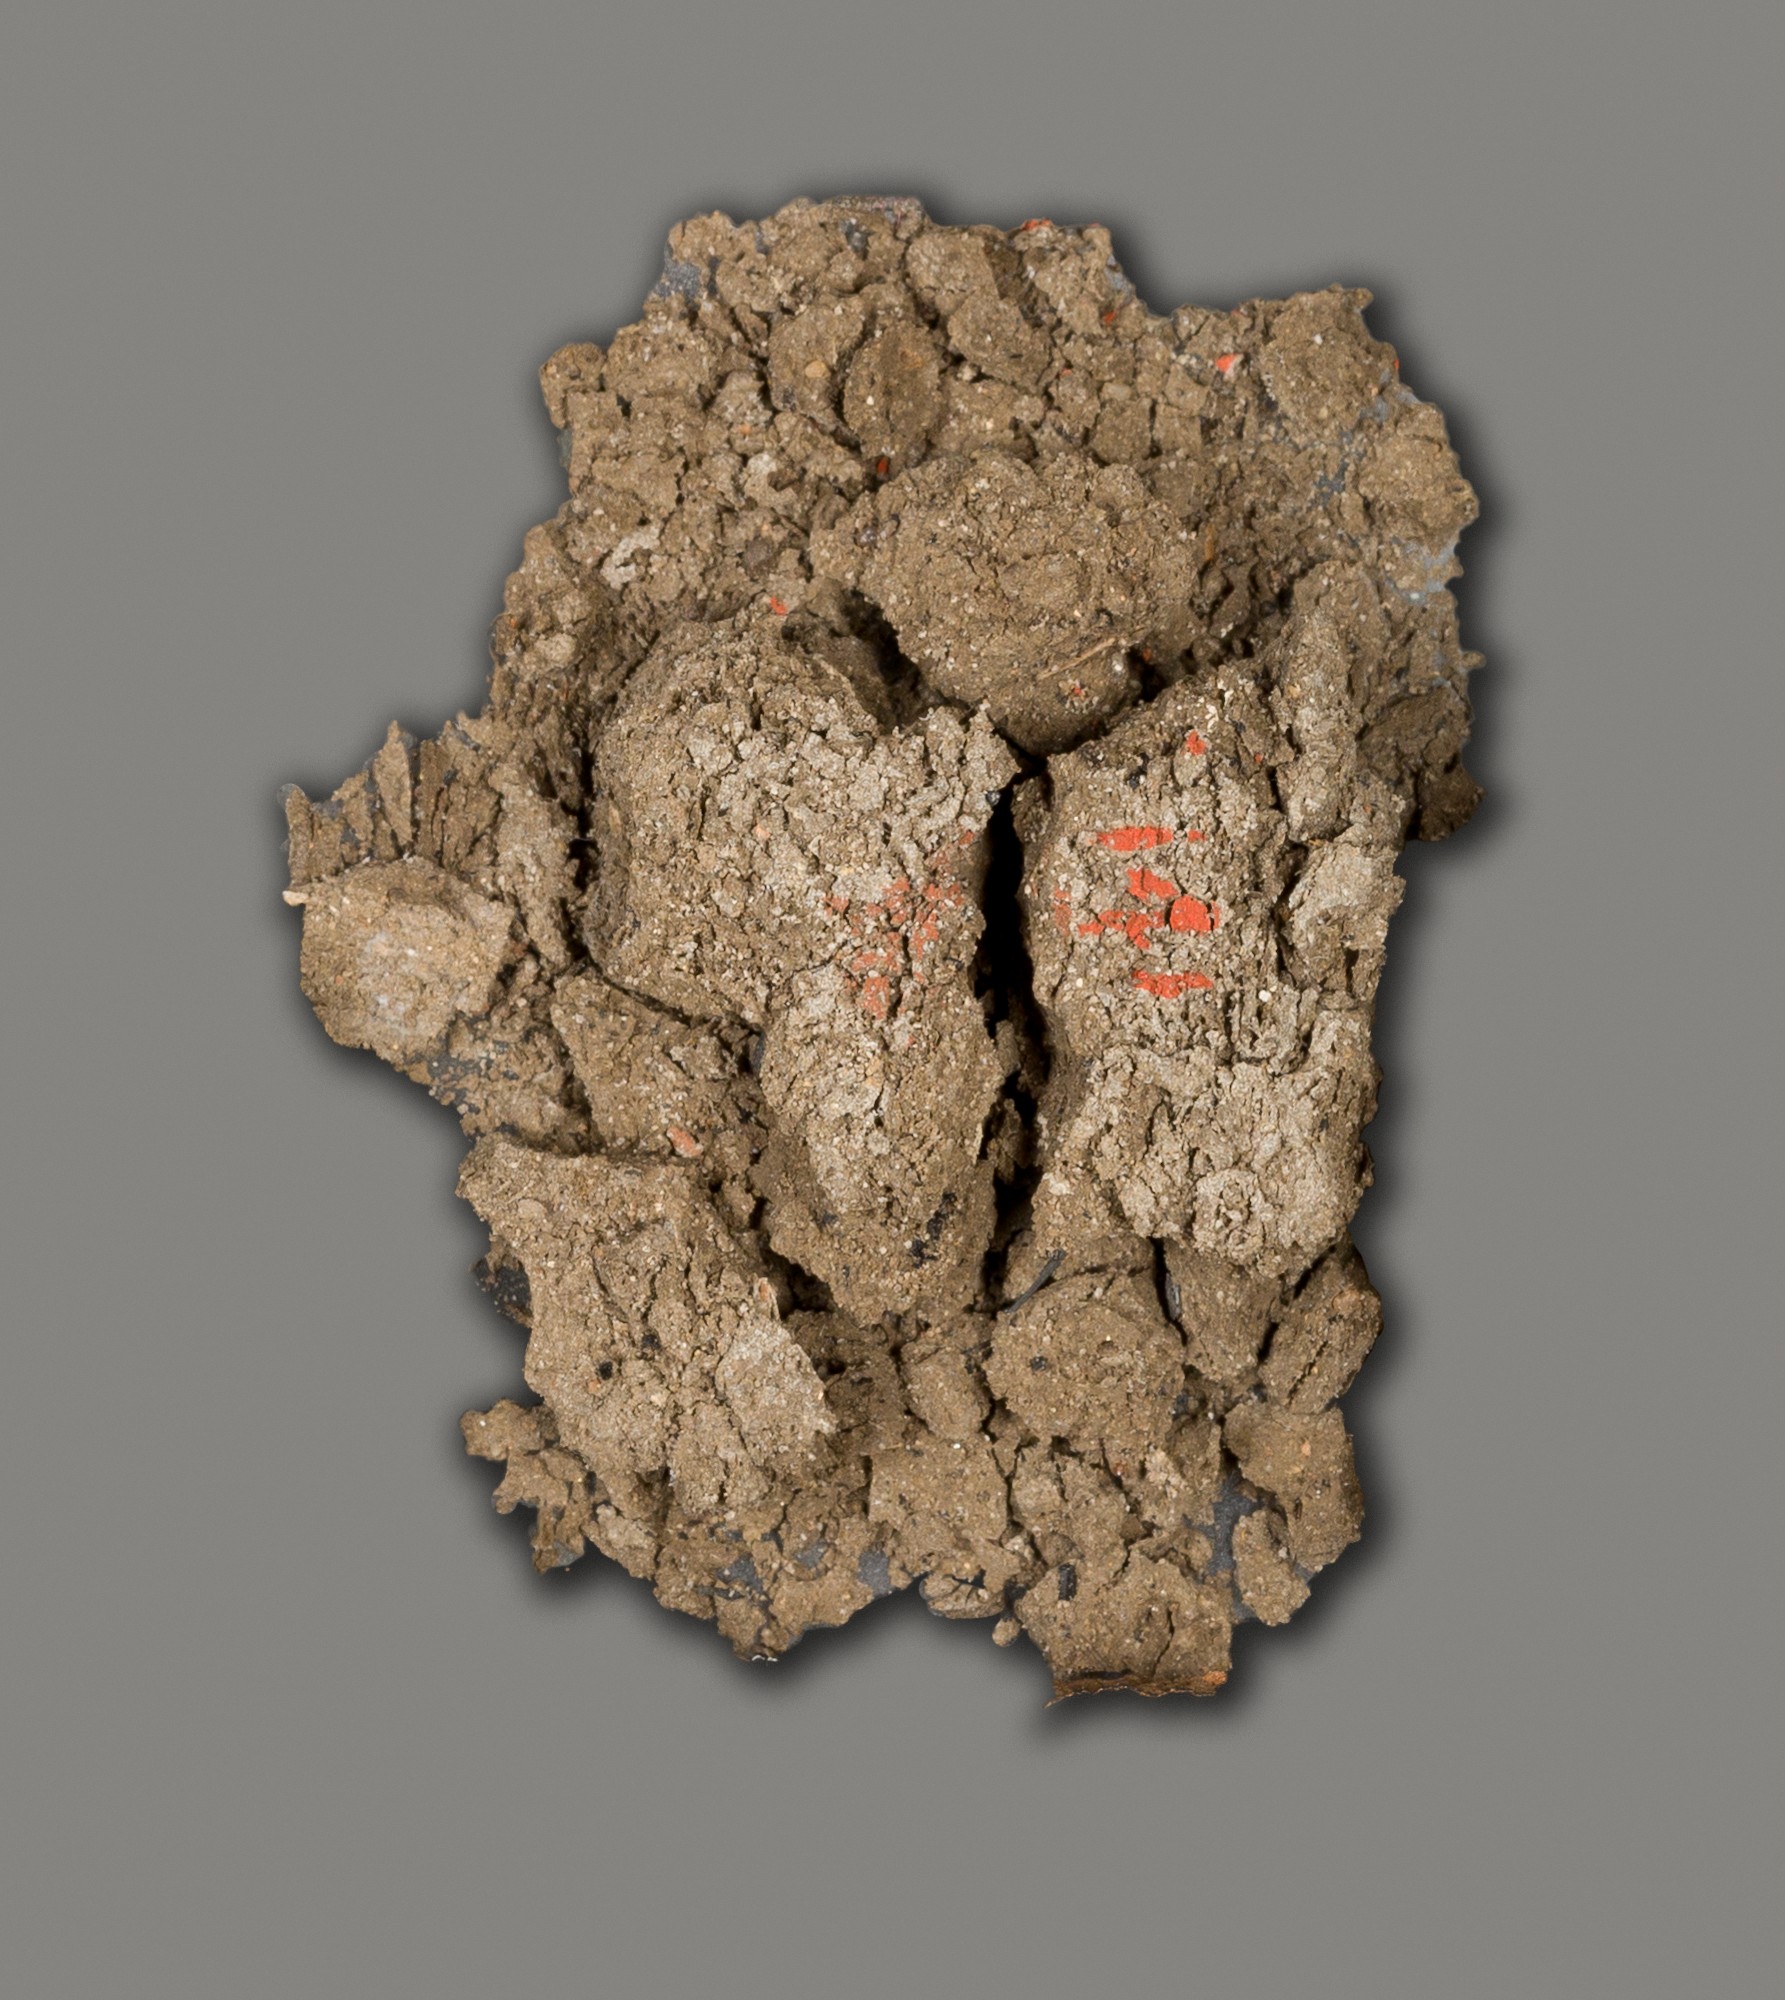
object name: figure, magical, execration, tablet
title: Magical Figure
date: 1802-1550 BCE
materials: clay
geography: egypt